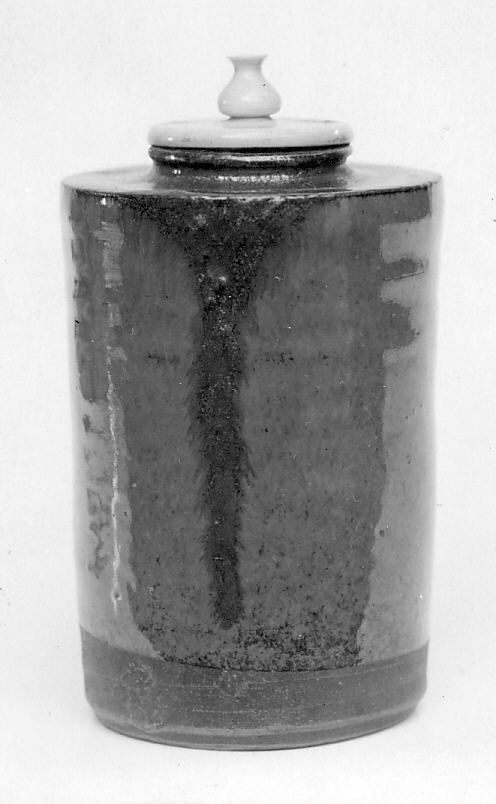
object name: tea jar with cover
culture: japanese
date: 1701-1800